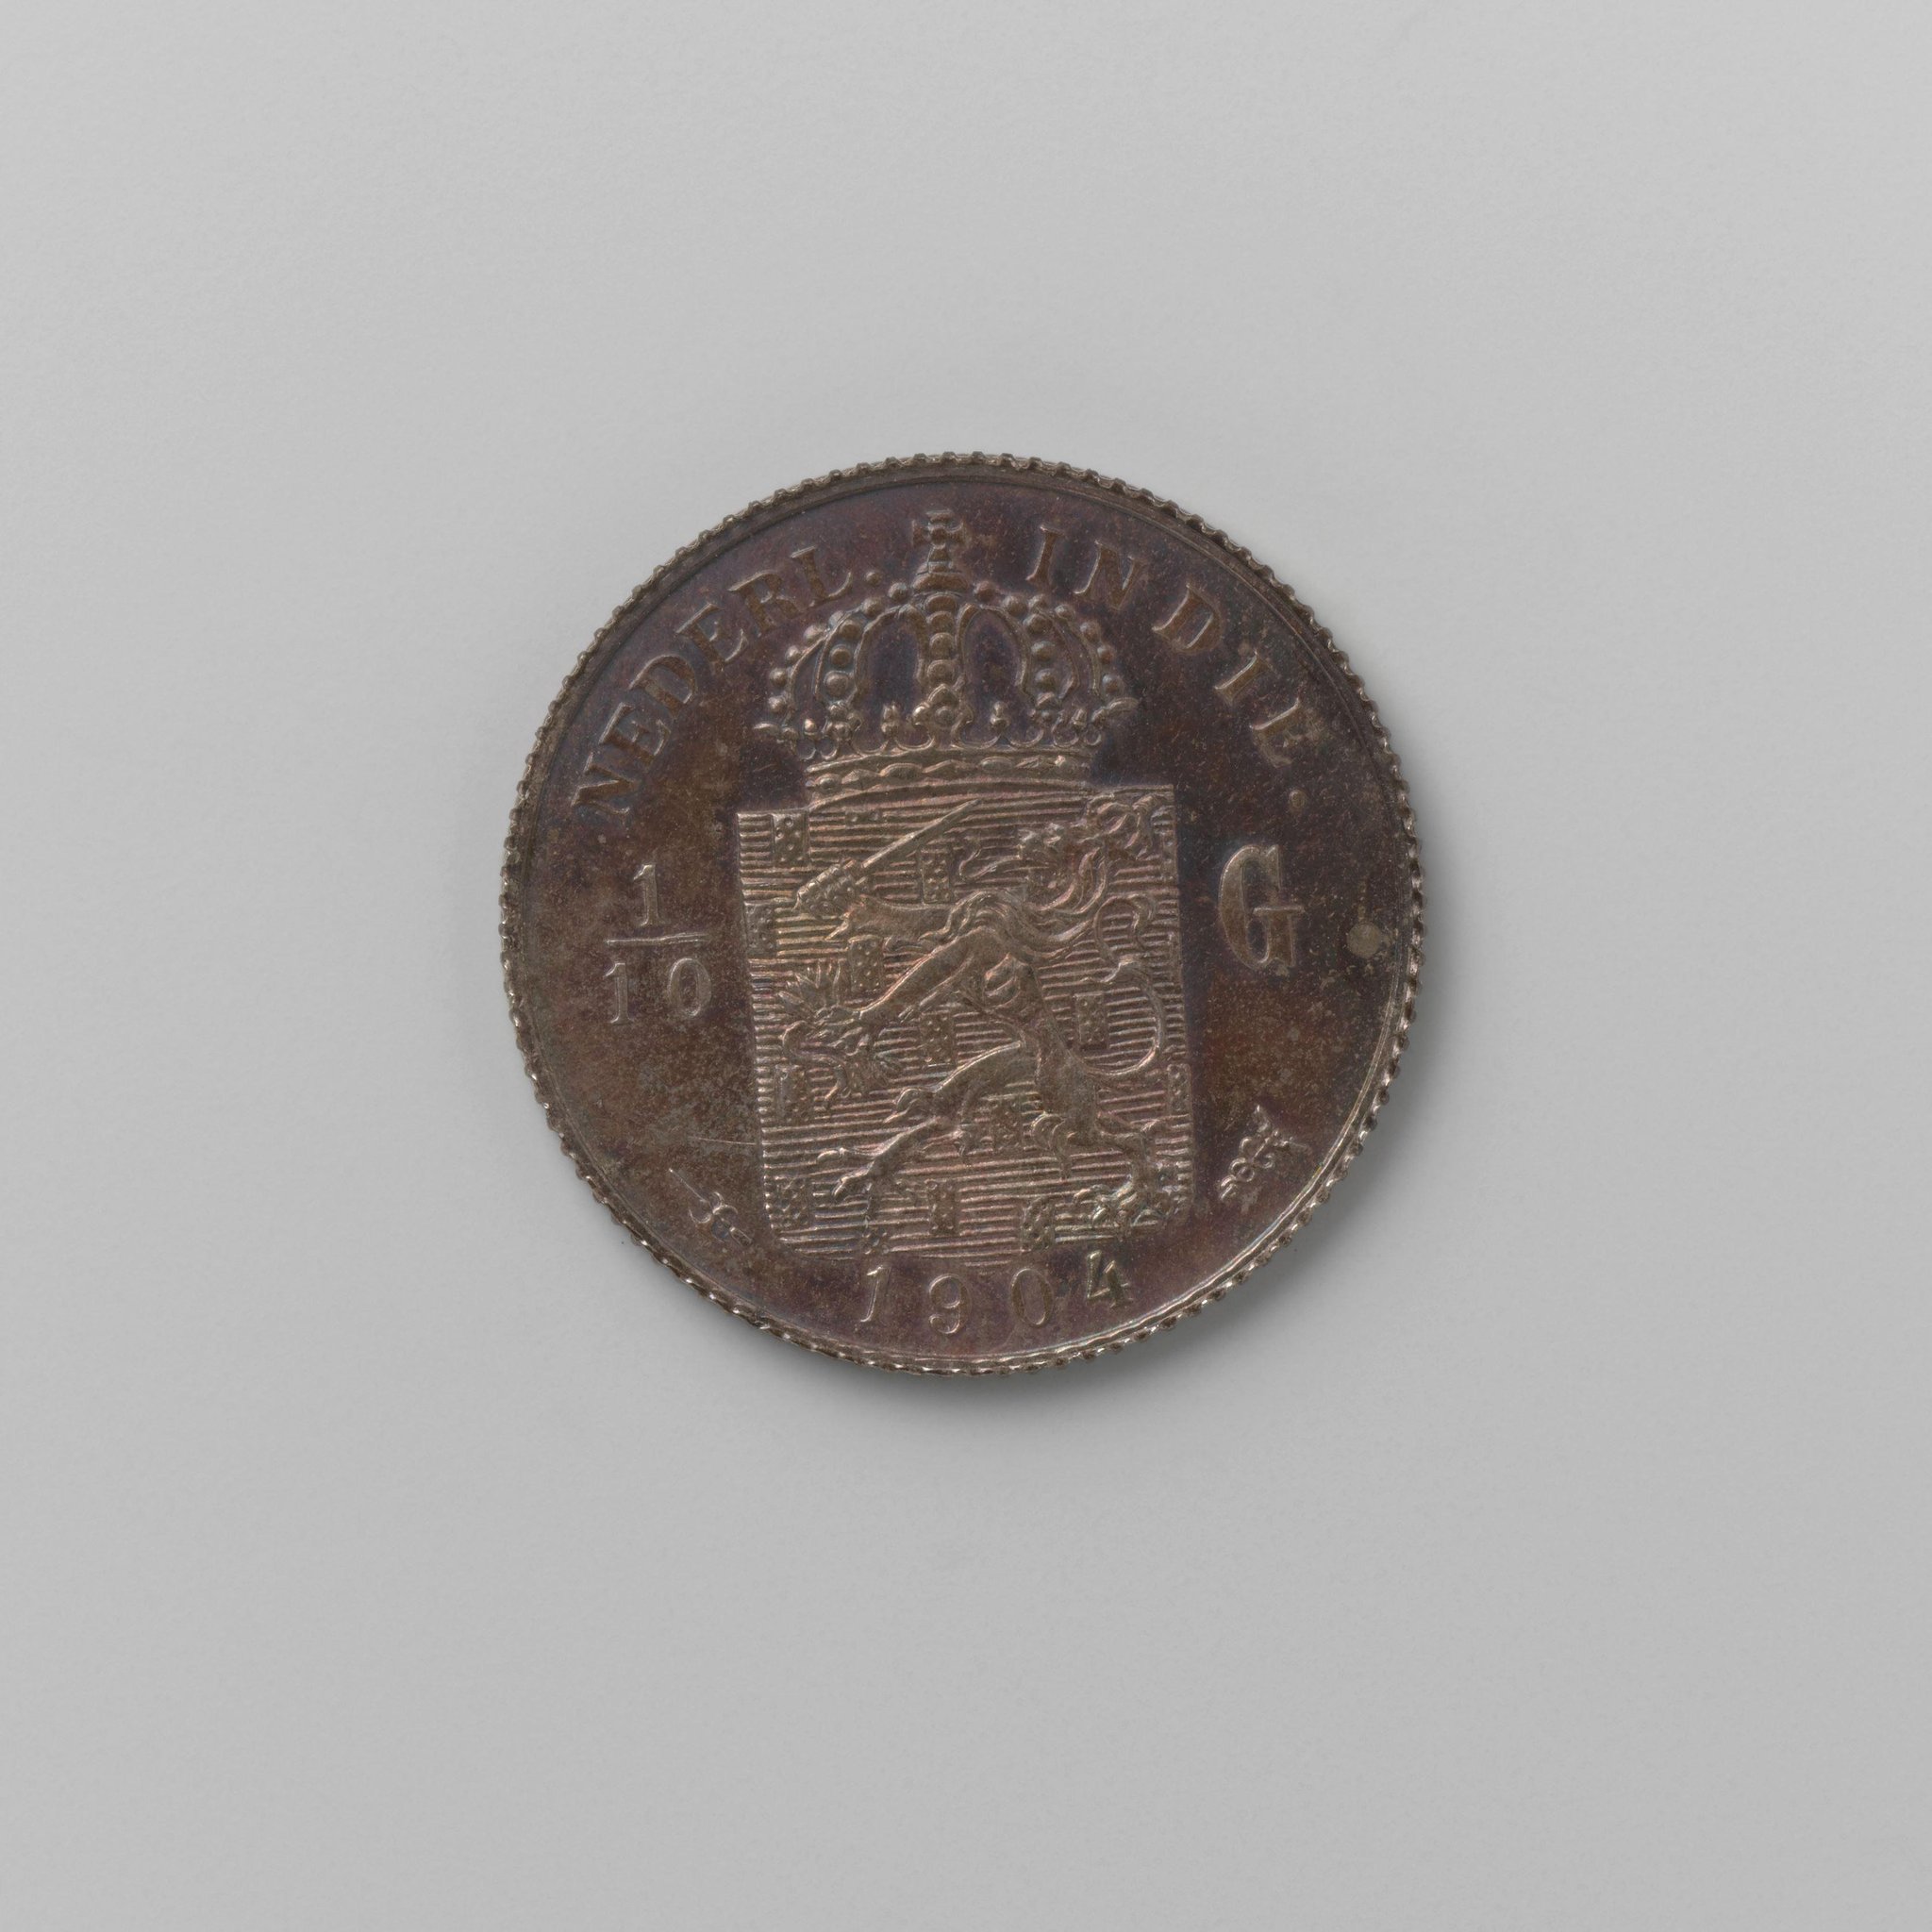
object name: coin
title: Nederlands Indië,1/10 gulden,1904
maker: wilhelmina of the netherlands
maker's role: print maker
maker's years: 1880-1962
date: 1904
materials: copper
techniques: striking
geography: utrecht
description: Zilveren munt. Voorzijde: tussen waarde-aanduiding 1/10 G gekroond rijkswapenschild. Boven kroon landsaanduiding en onder wapenschild jaartal. Keerzijde: tweeregelig Maleis opschrift in Arabische tekens, waaromheen omschrift in het Javaans. Kartelrand.